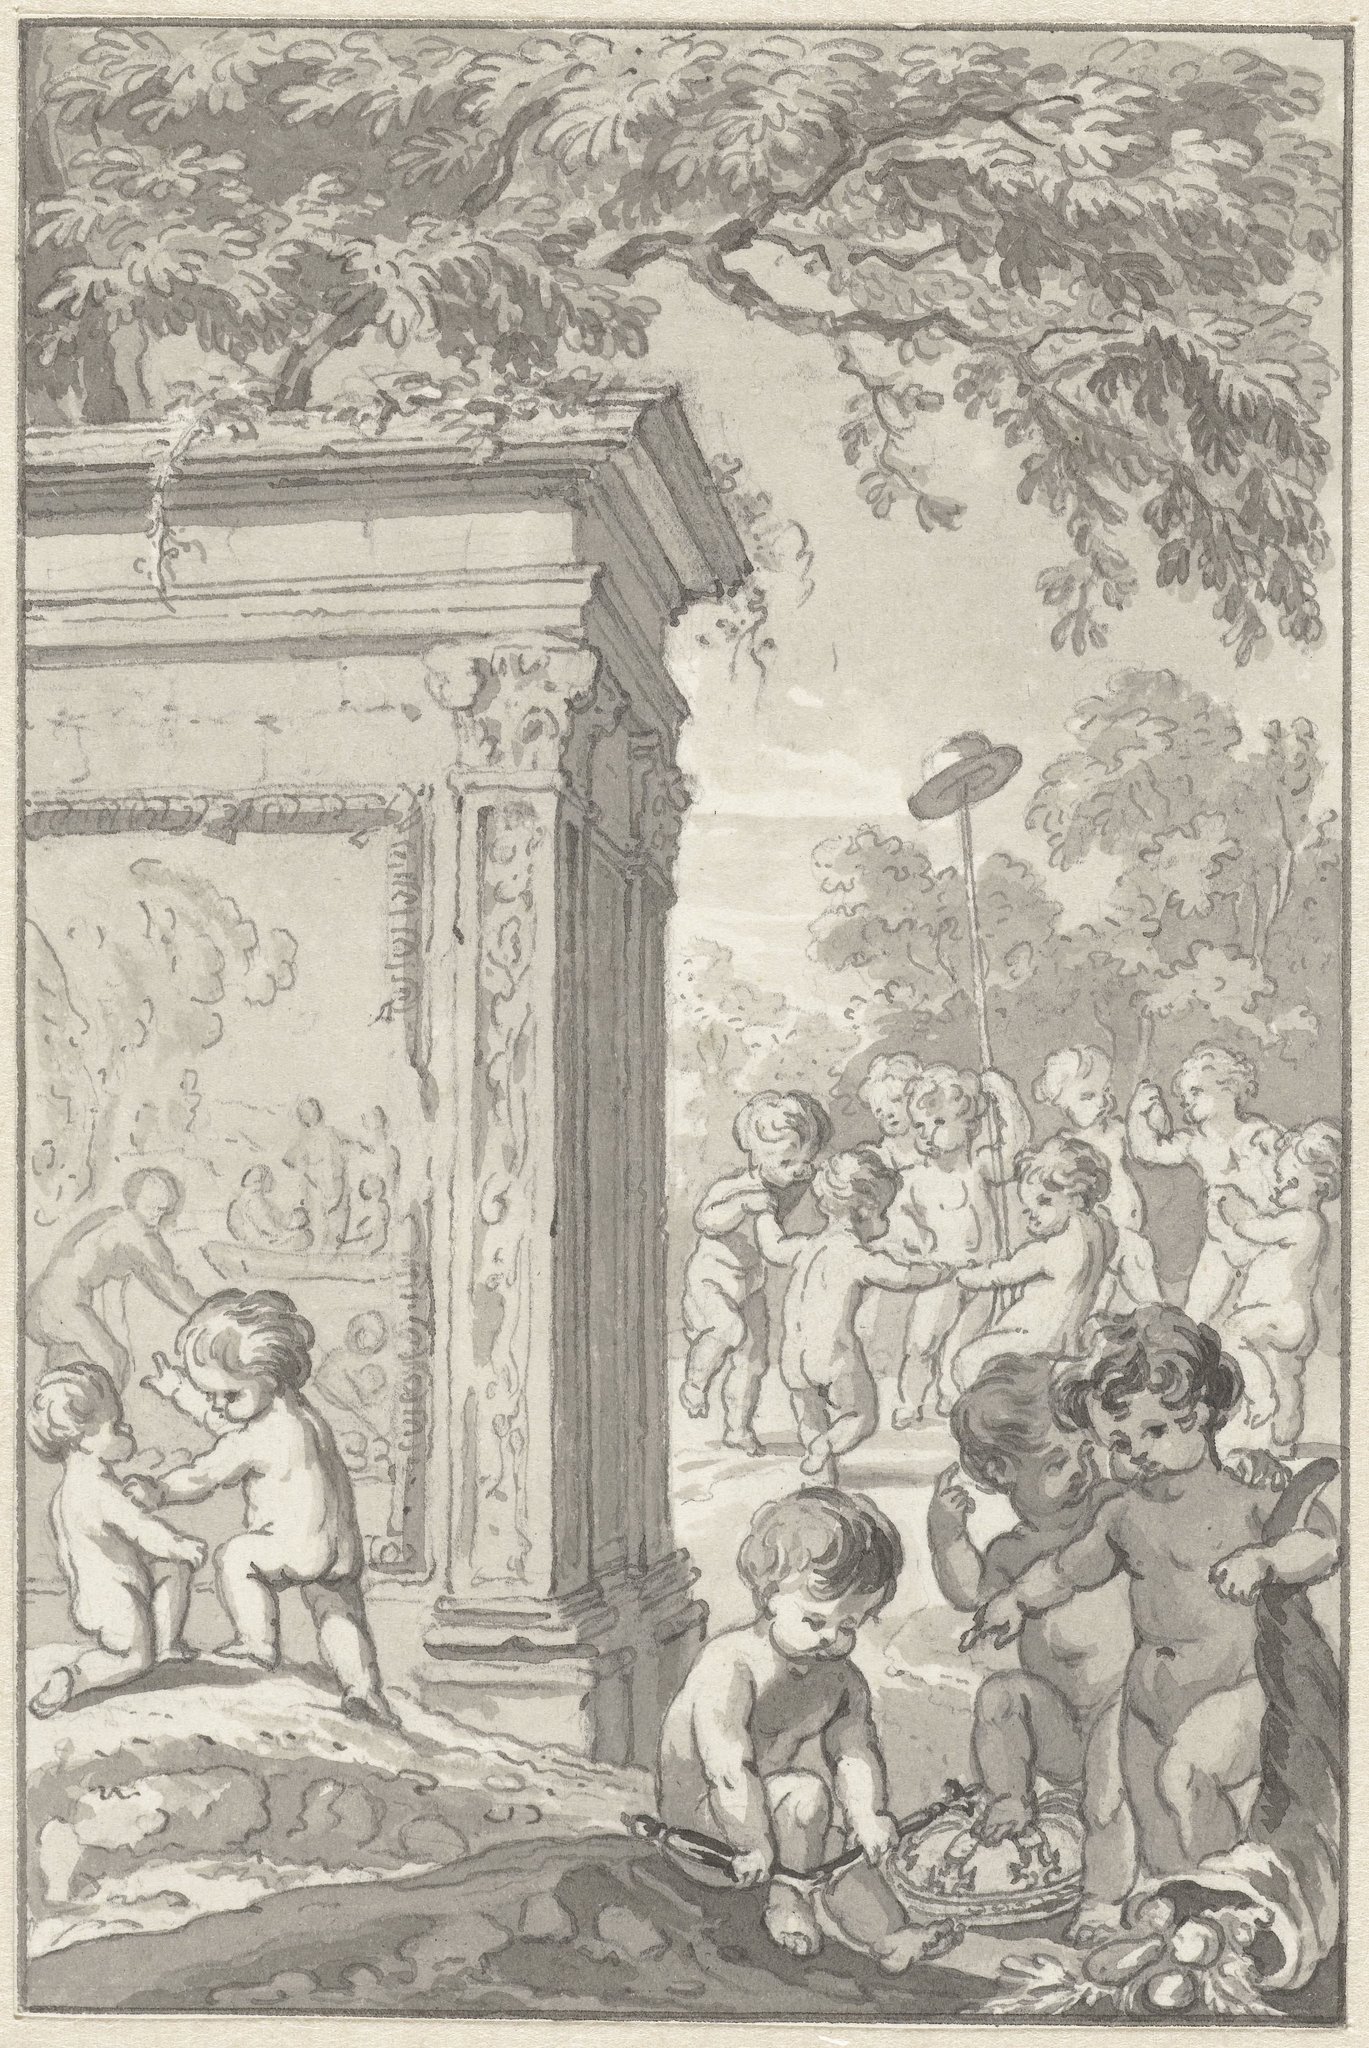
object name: drawing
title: Ontwerp voor titelpagina voor: Aloude Staat der Verenigde Nederlanden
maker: engelbertus matthias engelberts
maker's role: draughtsman, print maker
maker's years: 1731-1807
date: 1782-1784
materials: ink, paper, pencil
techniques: brush, pen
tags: symbols of particular nations, states, districts, etc., netherlands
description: Ontwerp voor titelpagina voor: E.M. Engelberts, De aloude staat en geschiedenissen der Vereenigde Nederlanden, Johannes Allart, Amsterdam 1784-1799.